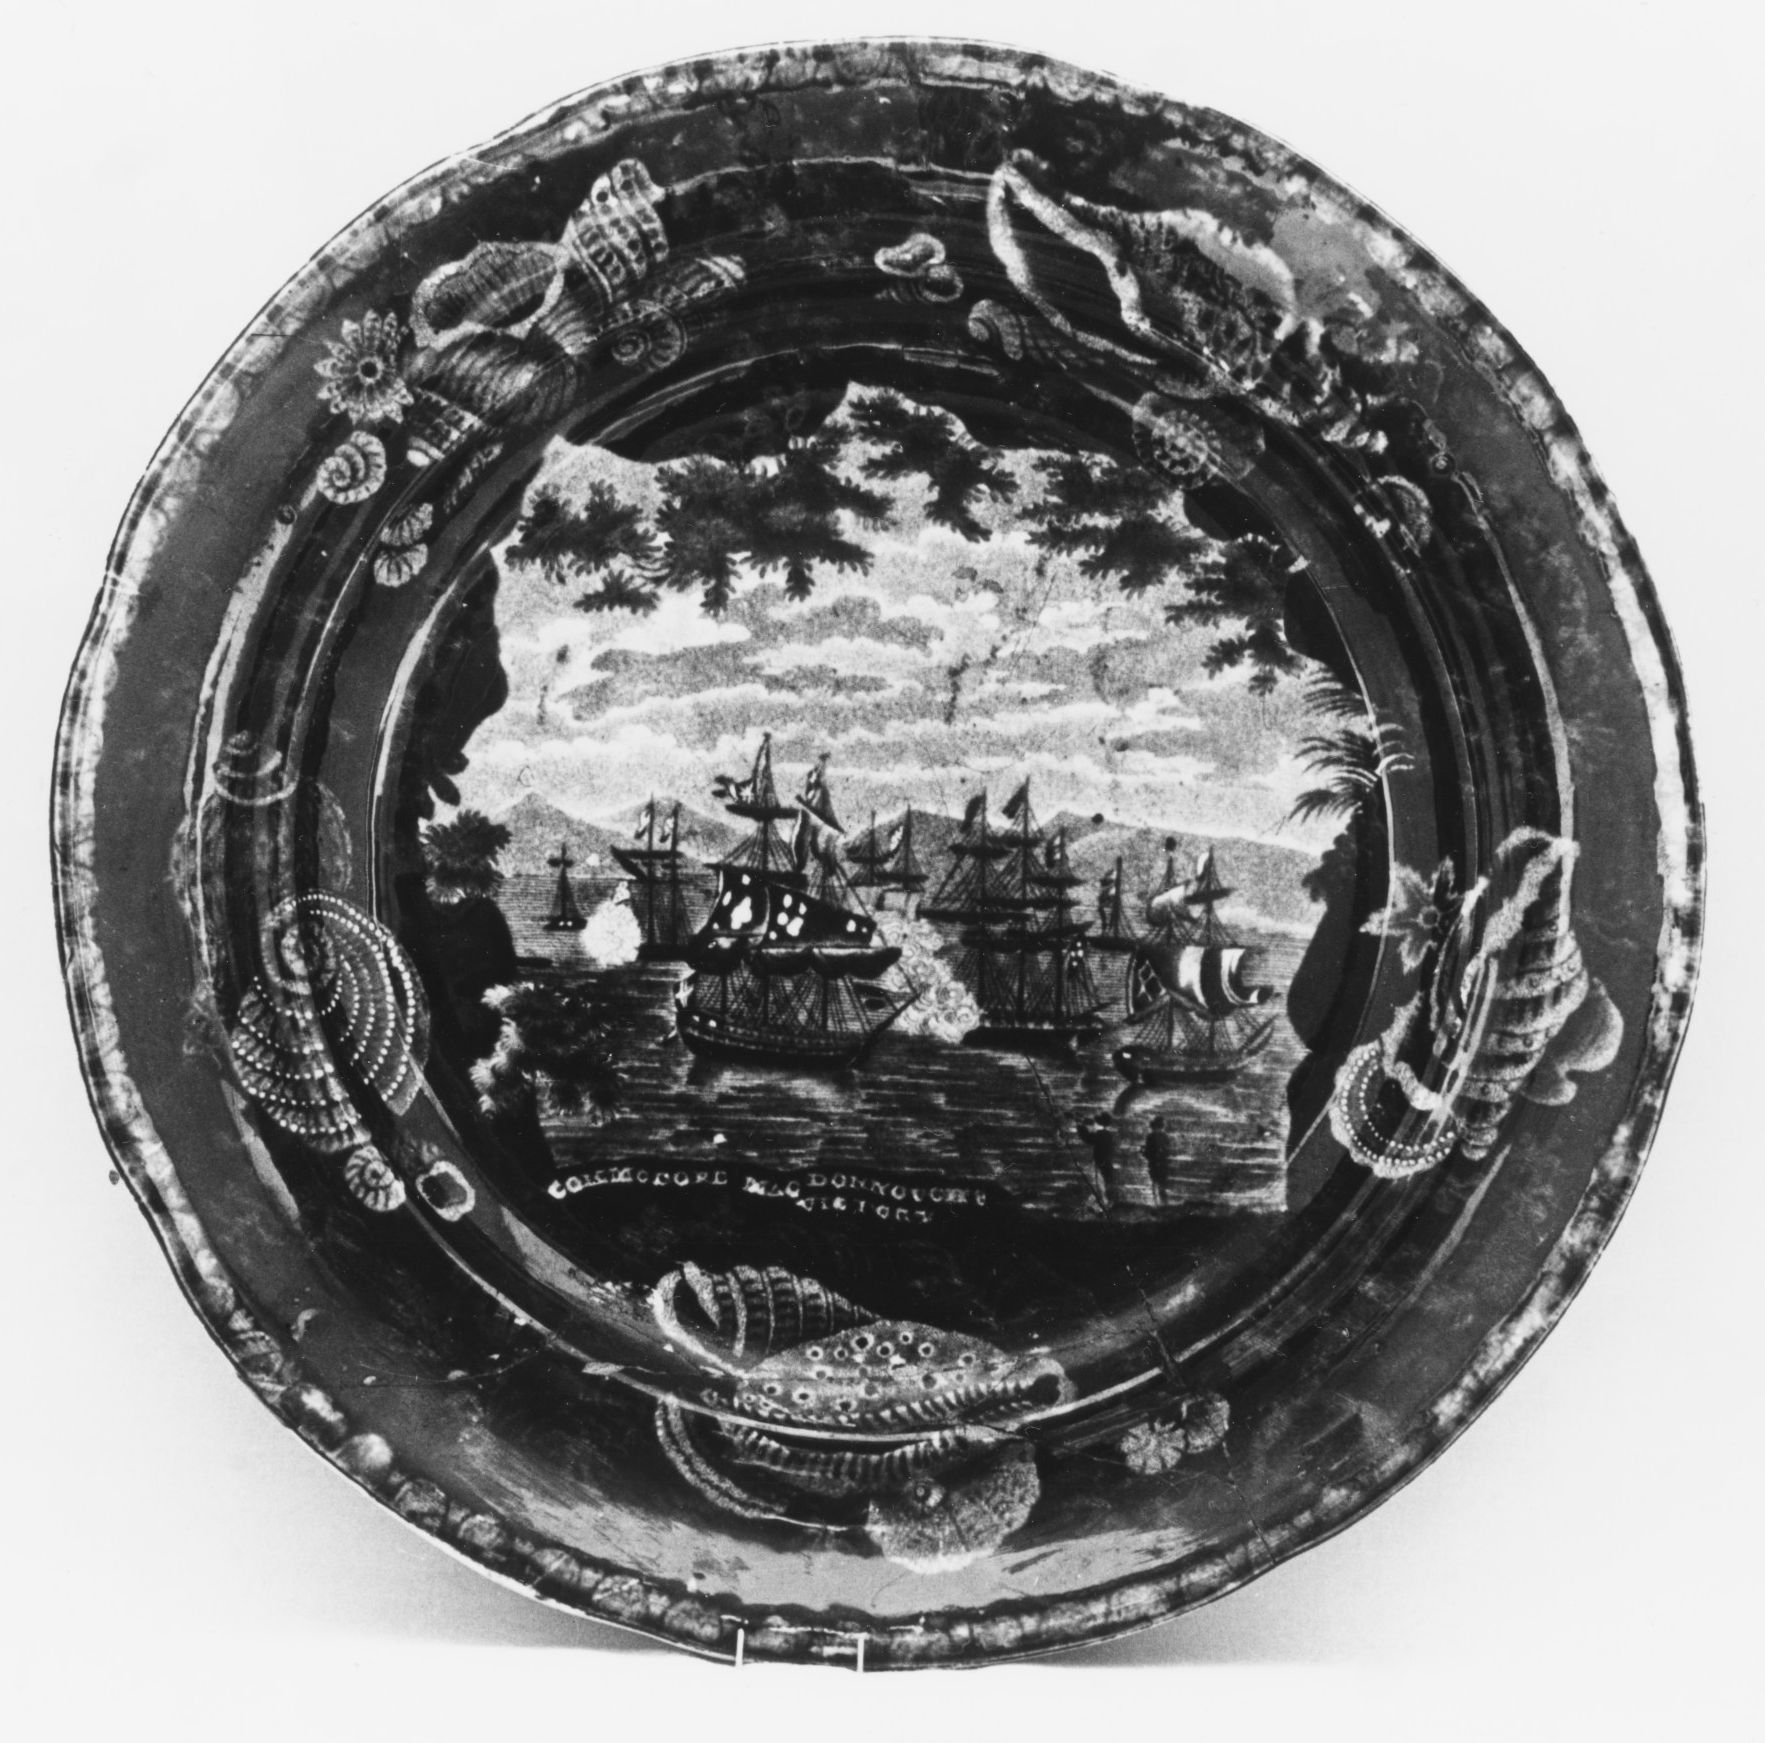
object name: plate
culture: british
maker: enoch wood & sons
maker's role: maker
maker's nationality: british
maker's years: 1818-1846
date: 1818-1846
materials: earthenware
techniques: transfer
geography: england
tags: ships